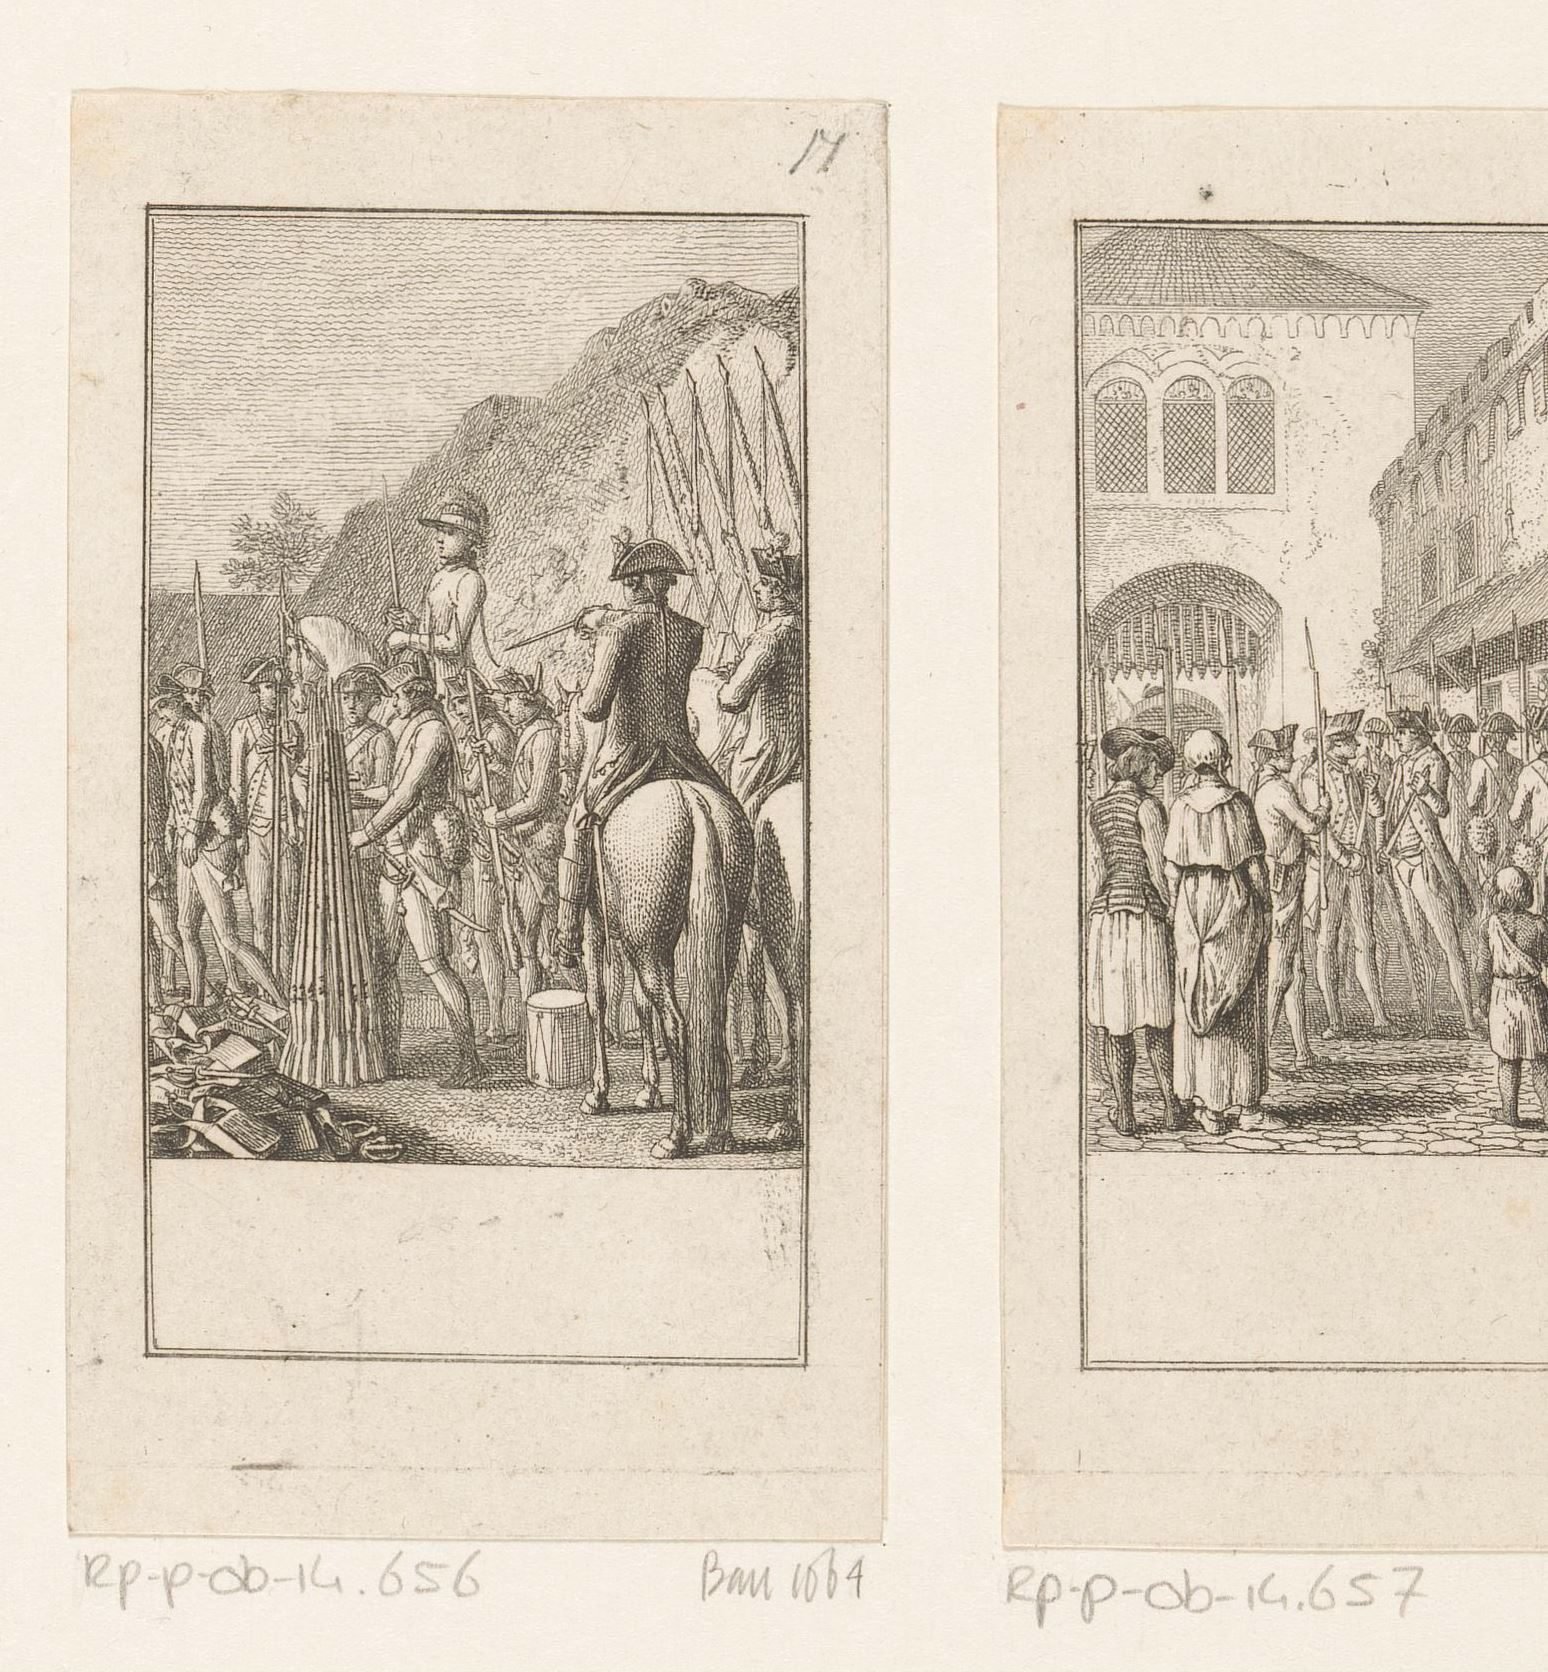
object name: print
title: Overgave bij Yorktown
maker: daniel nikolaus chodowiecki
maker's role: draughtsman, print maker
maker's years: 1726-1801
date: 1783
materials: paper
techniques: etching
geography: berlin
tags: landscapes, history, the soldier; the soldier's life, booty, spoil, surrender ~ war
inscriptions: collector's mark: Lugt 2228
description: Vervaardigd voor 'die Geschichte der Revolution von Nord-America', geschreven door M. C. Sprengel. Latere staat gebruikt in: Historisch genealogischer Calender, oder Jahrbuch der merkwürdigsten neuen Welt-Begebenheiten für 1784. Leipzig: Zur Messe bey Haude und Spener von Berlin, [1784].